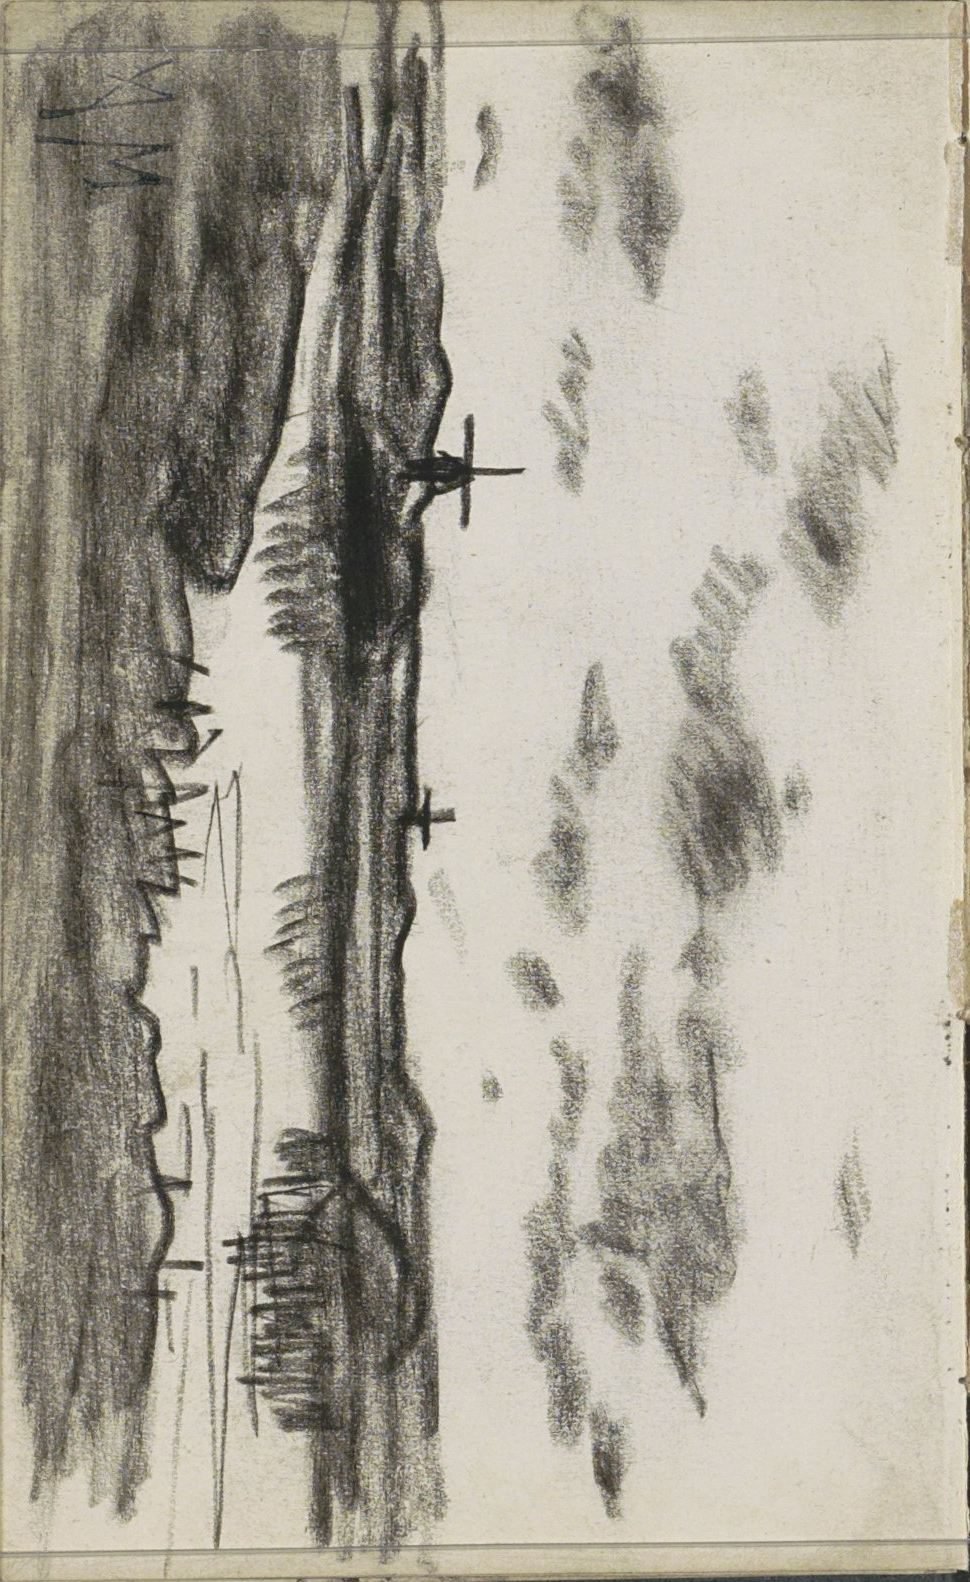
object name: sketchbook leaf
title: Rivierlandschap met molens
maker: anton mauve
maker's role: draughtsman, painter, print maker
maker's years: 1838-1888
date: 1848-1888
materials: chalk, paper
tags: windmill in landscape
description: Blad 8 verso uit een schetsboek met 53 bladen.